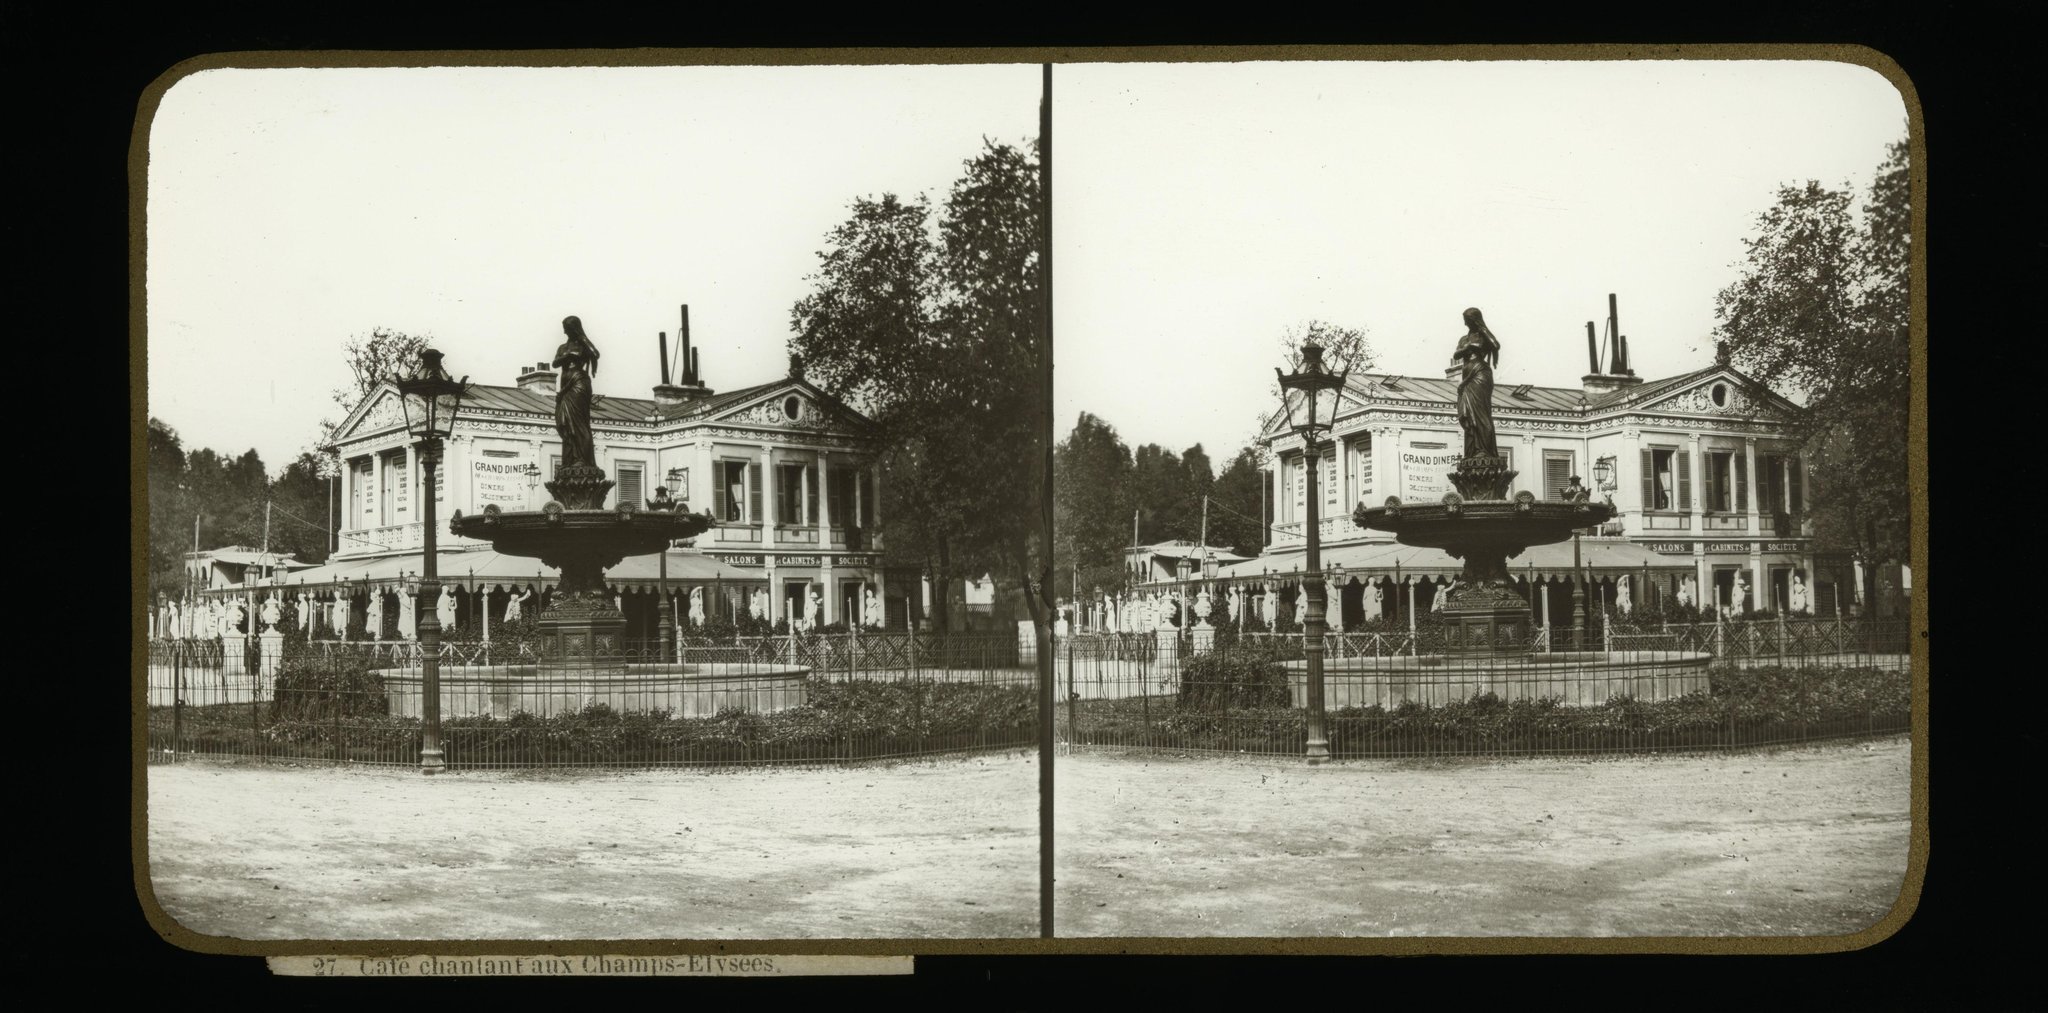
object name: stereoscopic photograph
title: Gezicht op een café aan de Champs-Elysées in Parijs, Frankrijk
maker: Anonymous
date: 1856-1890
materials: glass, paper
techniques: slide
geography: paris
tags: square, place, circus, etc., inn, coffee-house, public house, etc.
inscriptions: number: ‘27’, retailer's mark: ‘Péristyle Valois, Palais-Royal./ adosse au jardin, près d a galerie d'Orléans/ ALEXIS FAY/ Opticien: Grande Spécialité d[.] Stéréoscopes et Microscopes./ [...]’